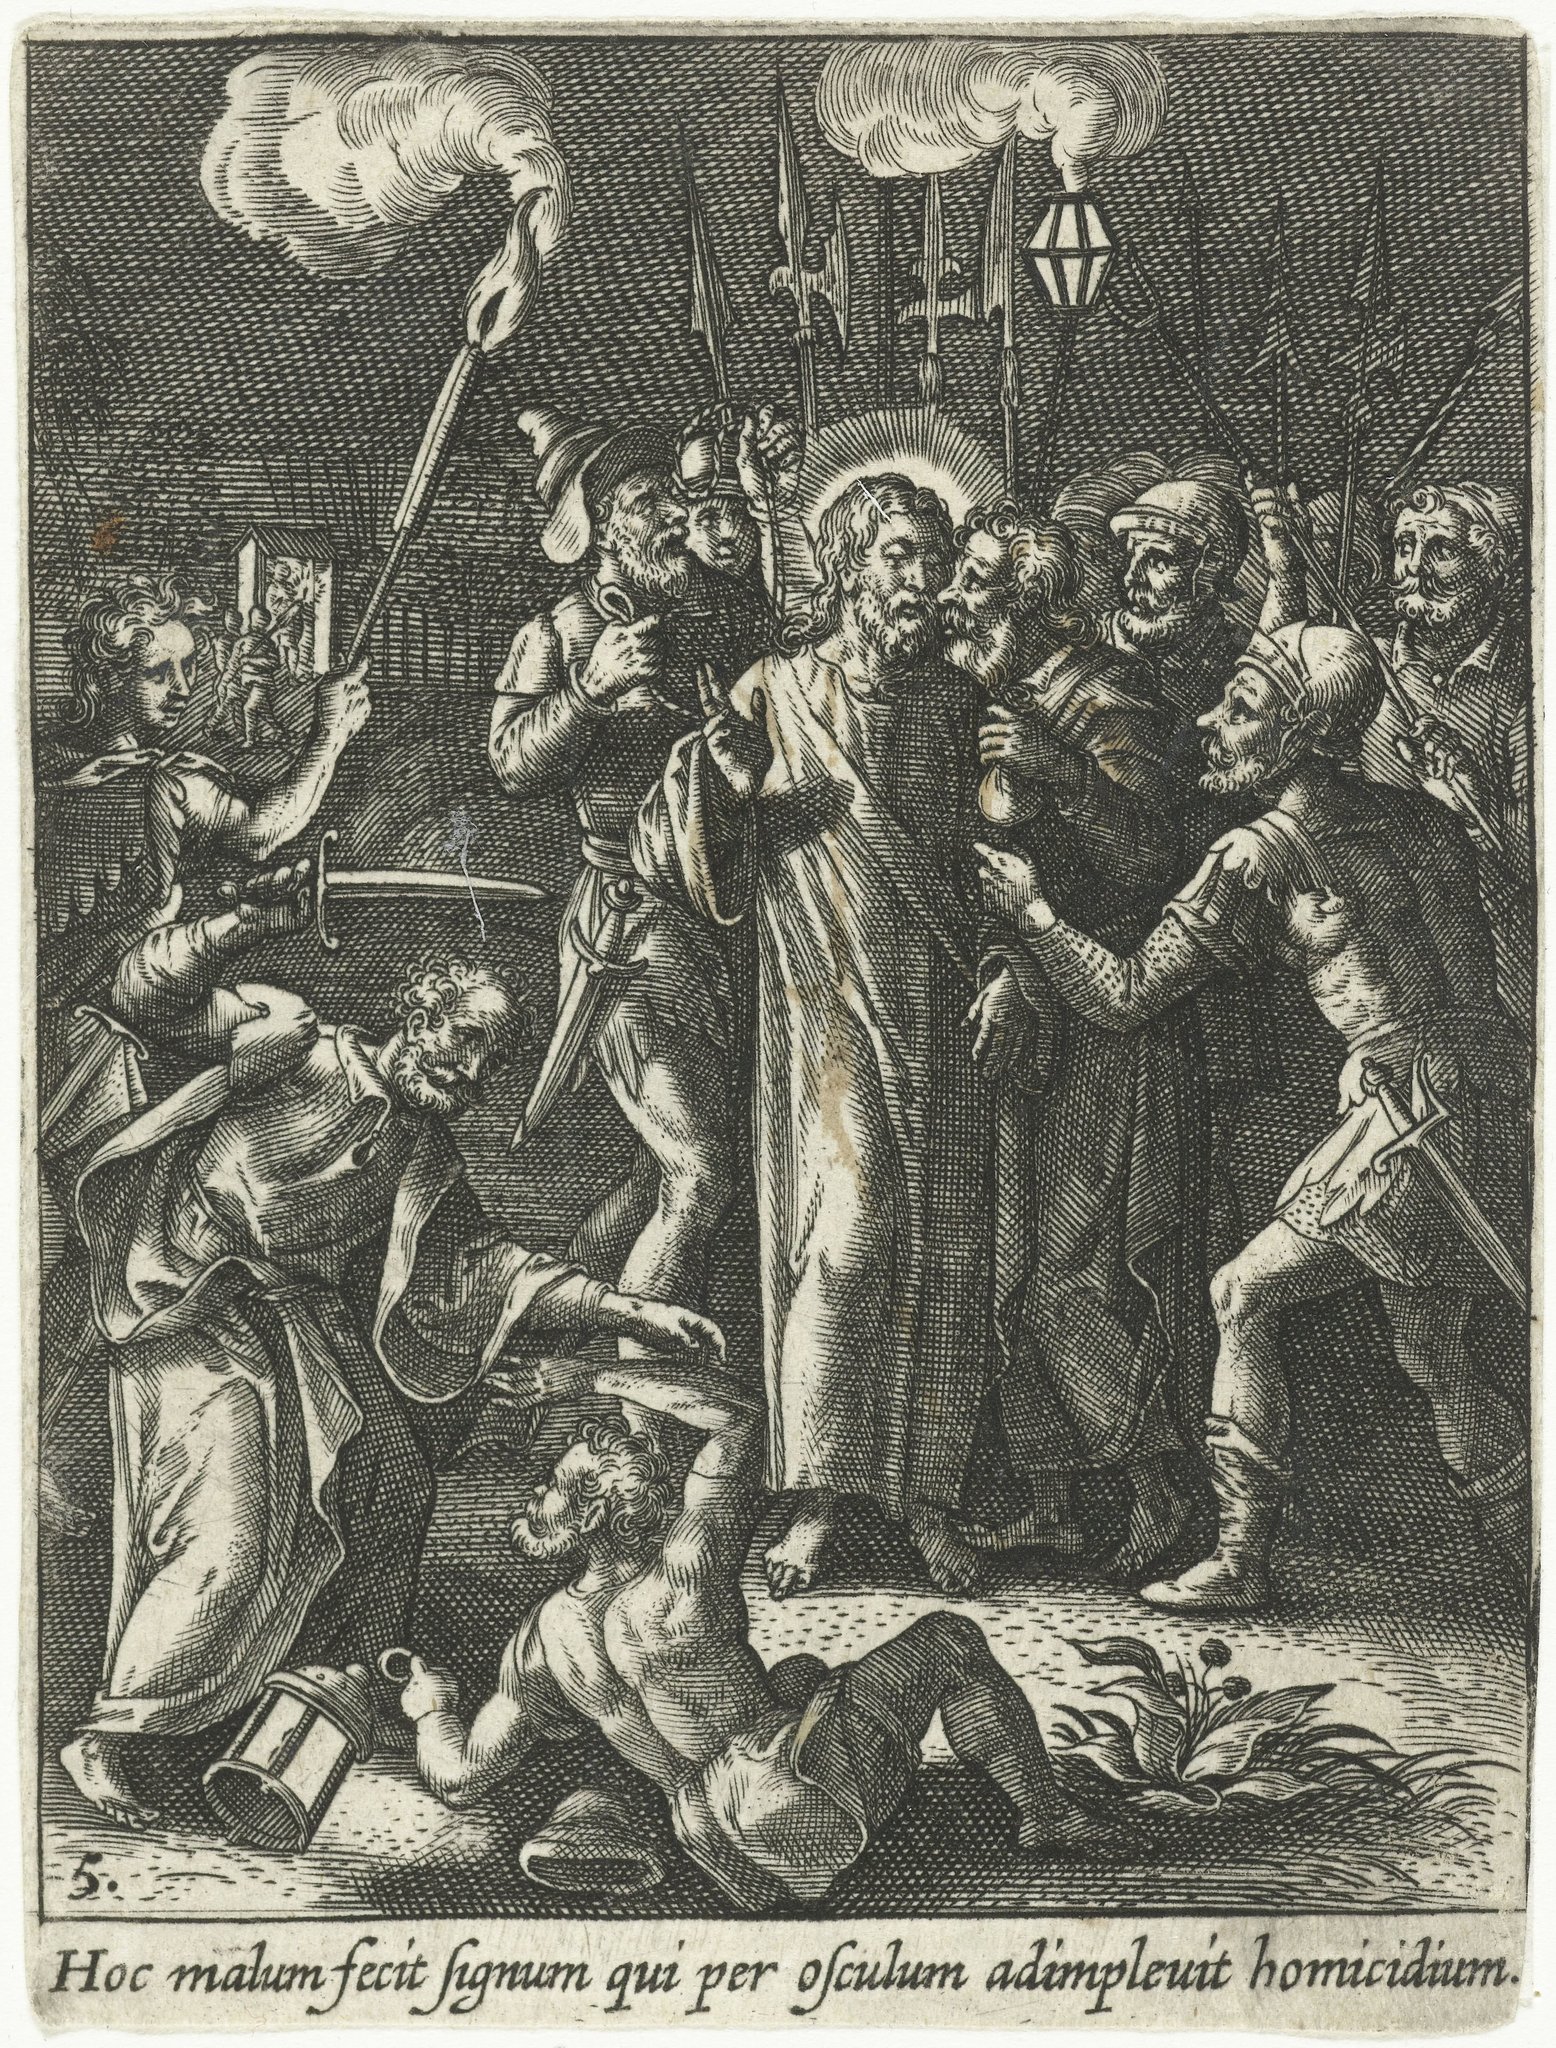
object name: print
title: Passie en wederopstanding van Christus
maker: adriaen collaert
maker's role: draughtsman, print maker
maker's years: 1560-1618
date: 1570-1618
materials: paper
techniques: engraving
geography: antwerp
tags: peter draws his sword and cuts off malchus' ear, the kiss of judas: accompanied by soldiers with torches and lanterns, he kisses christ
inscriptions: collector's mark: Lugt 240, collector's mark: Lugt 2228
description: Judas kust Christus op de wang. De soldaten omsingelen en arresteren hem. Petrus probeert een soldaat te verjagen. De prent heeft een Latijns onderschrift